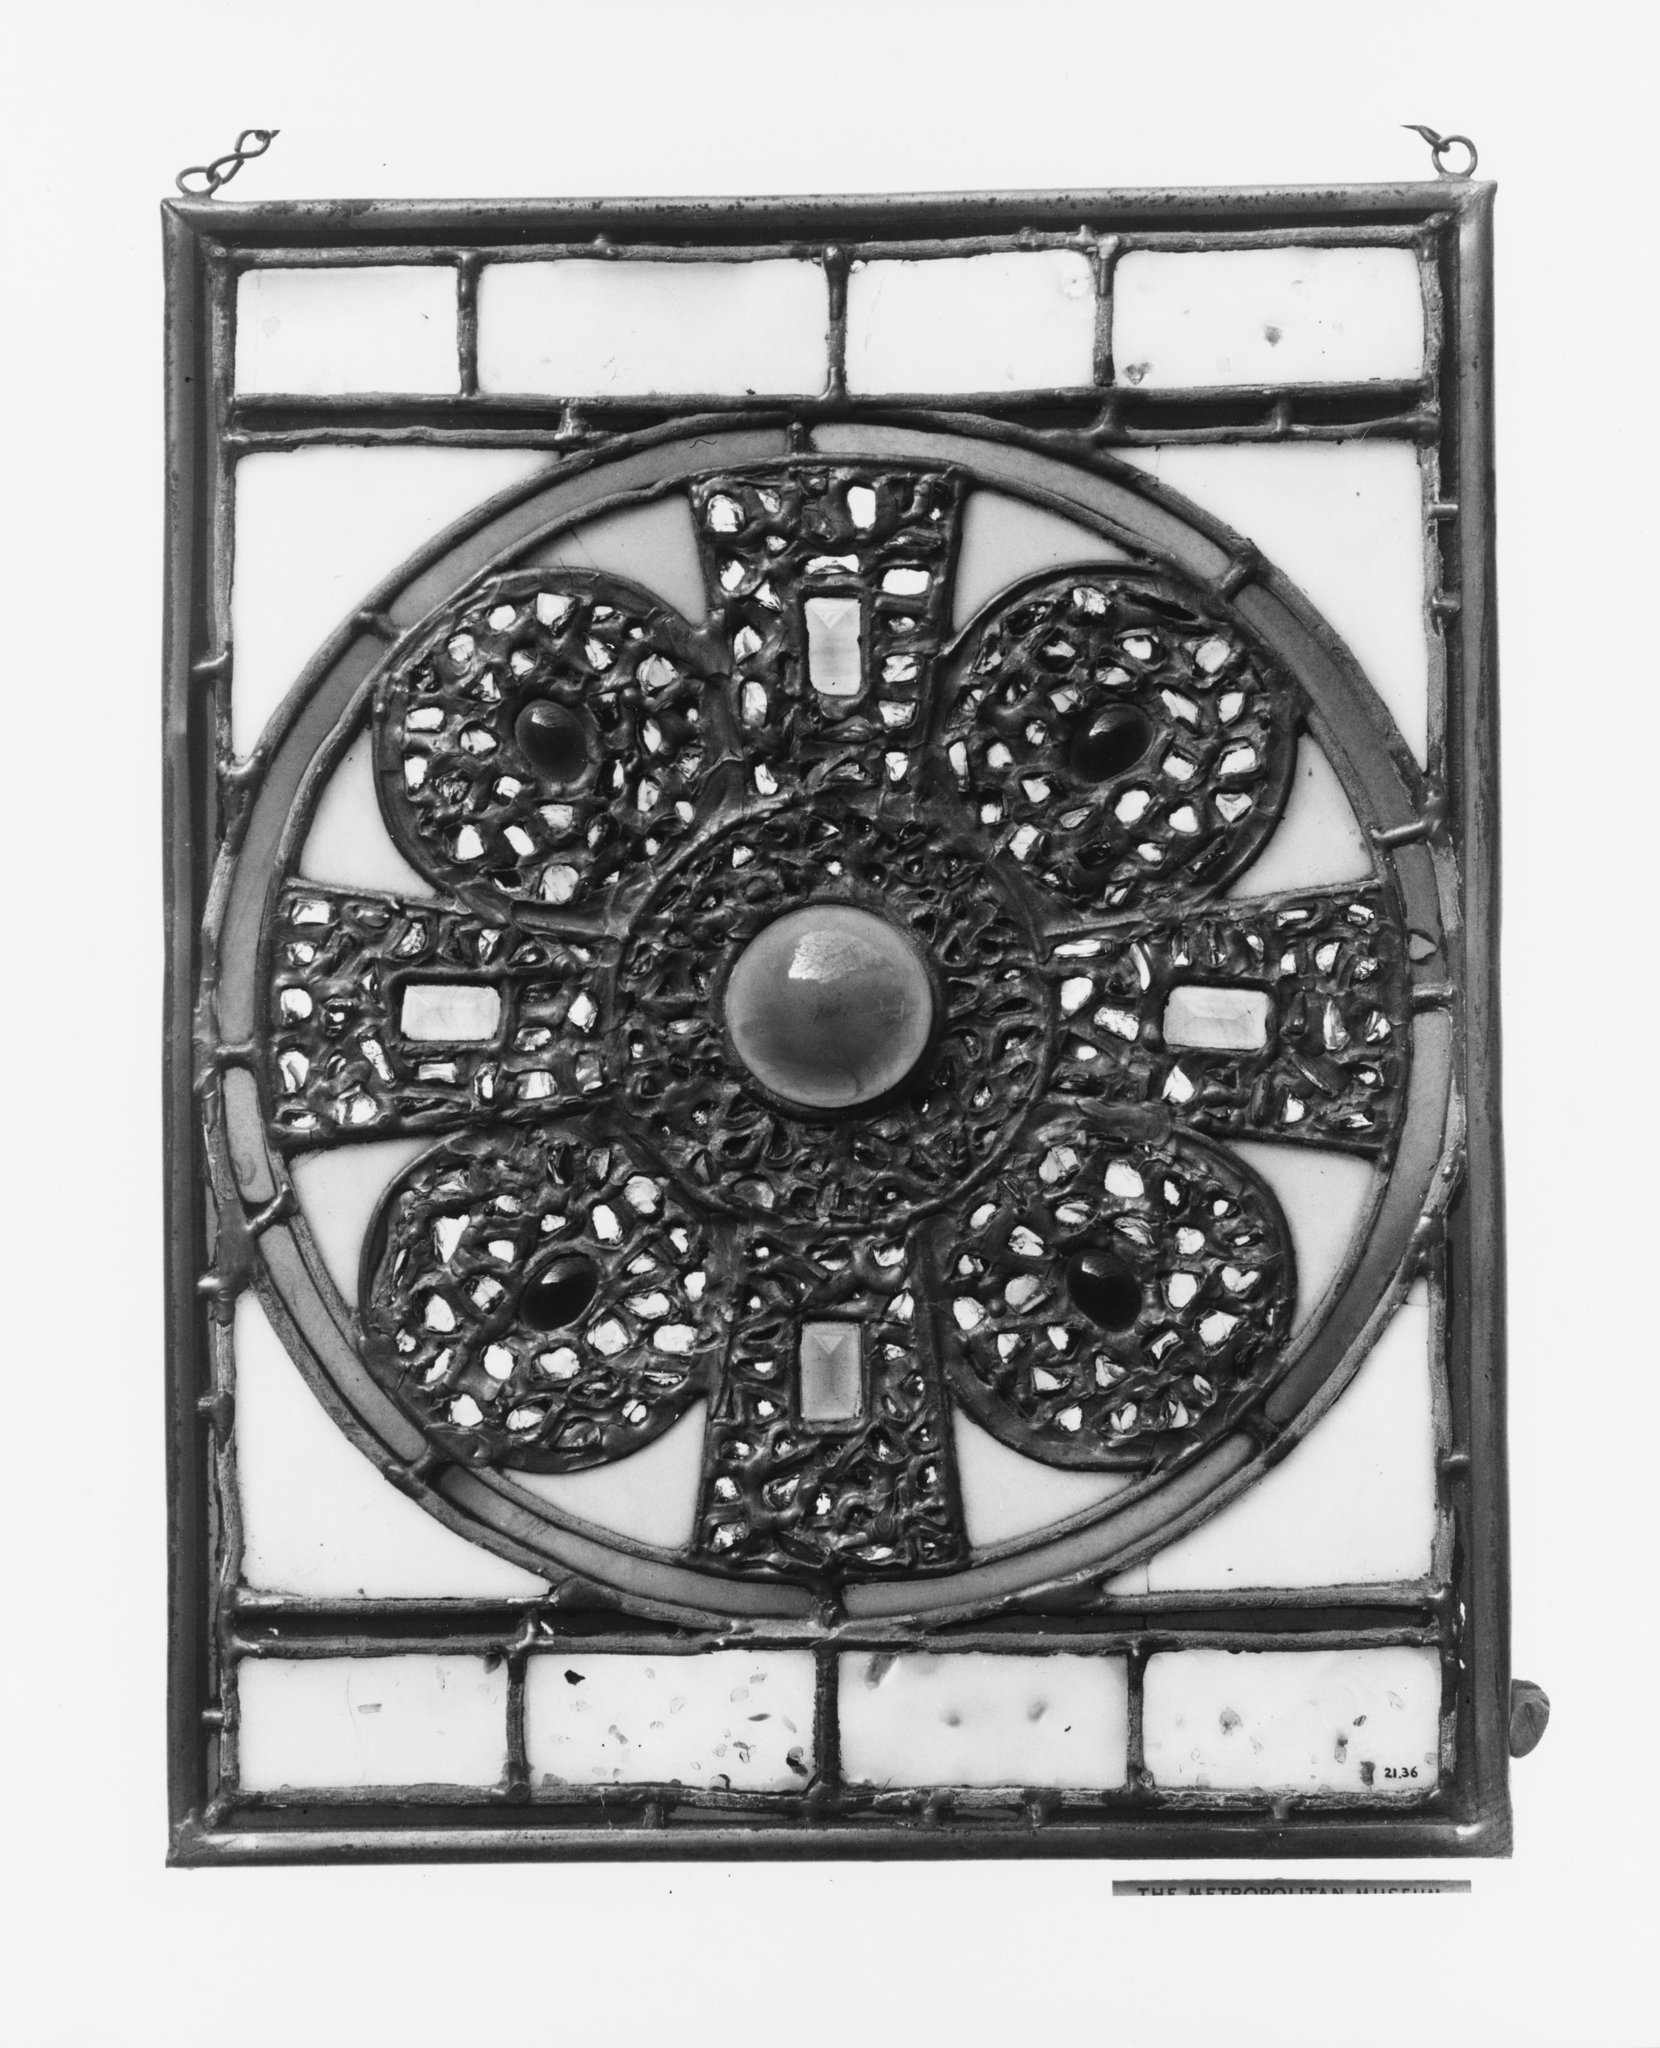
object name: stained glass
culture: american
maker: john la farge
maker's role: maker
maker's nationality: american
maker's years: 1835-1910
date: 1881-1882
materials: glass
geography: united states